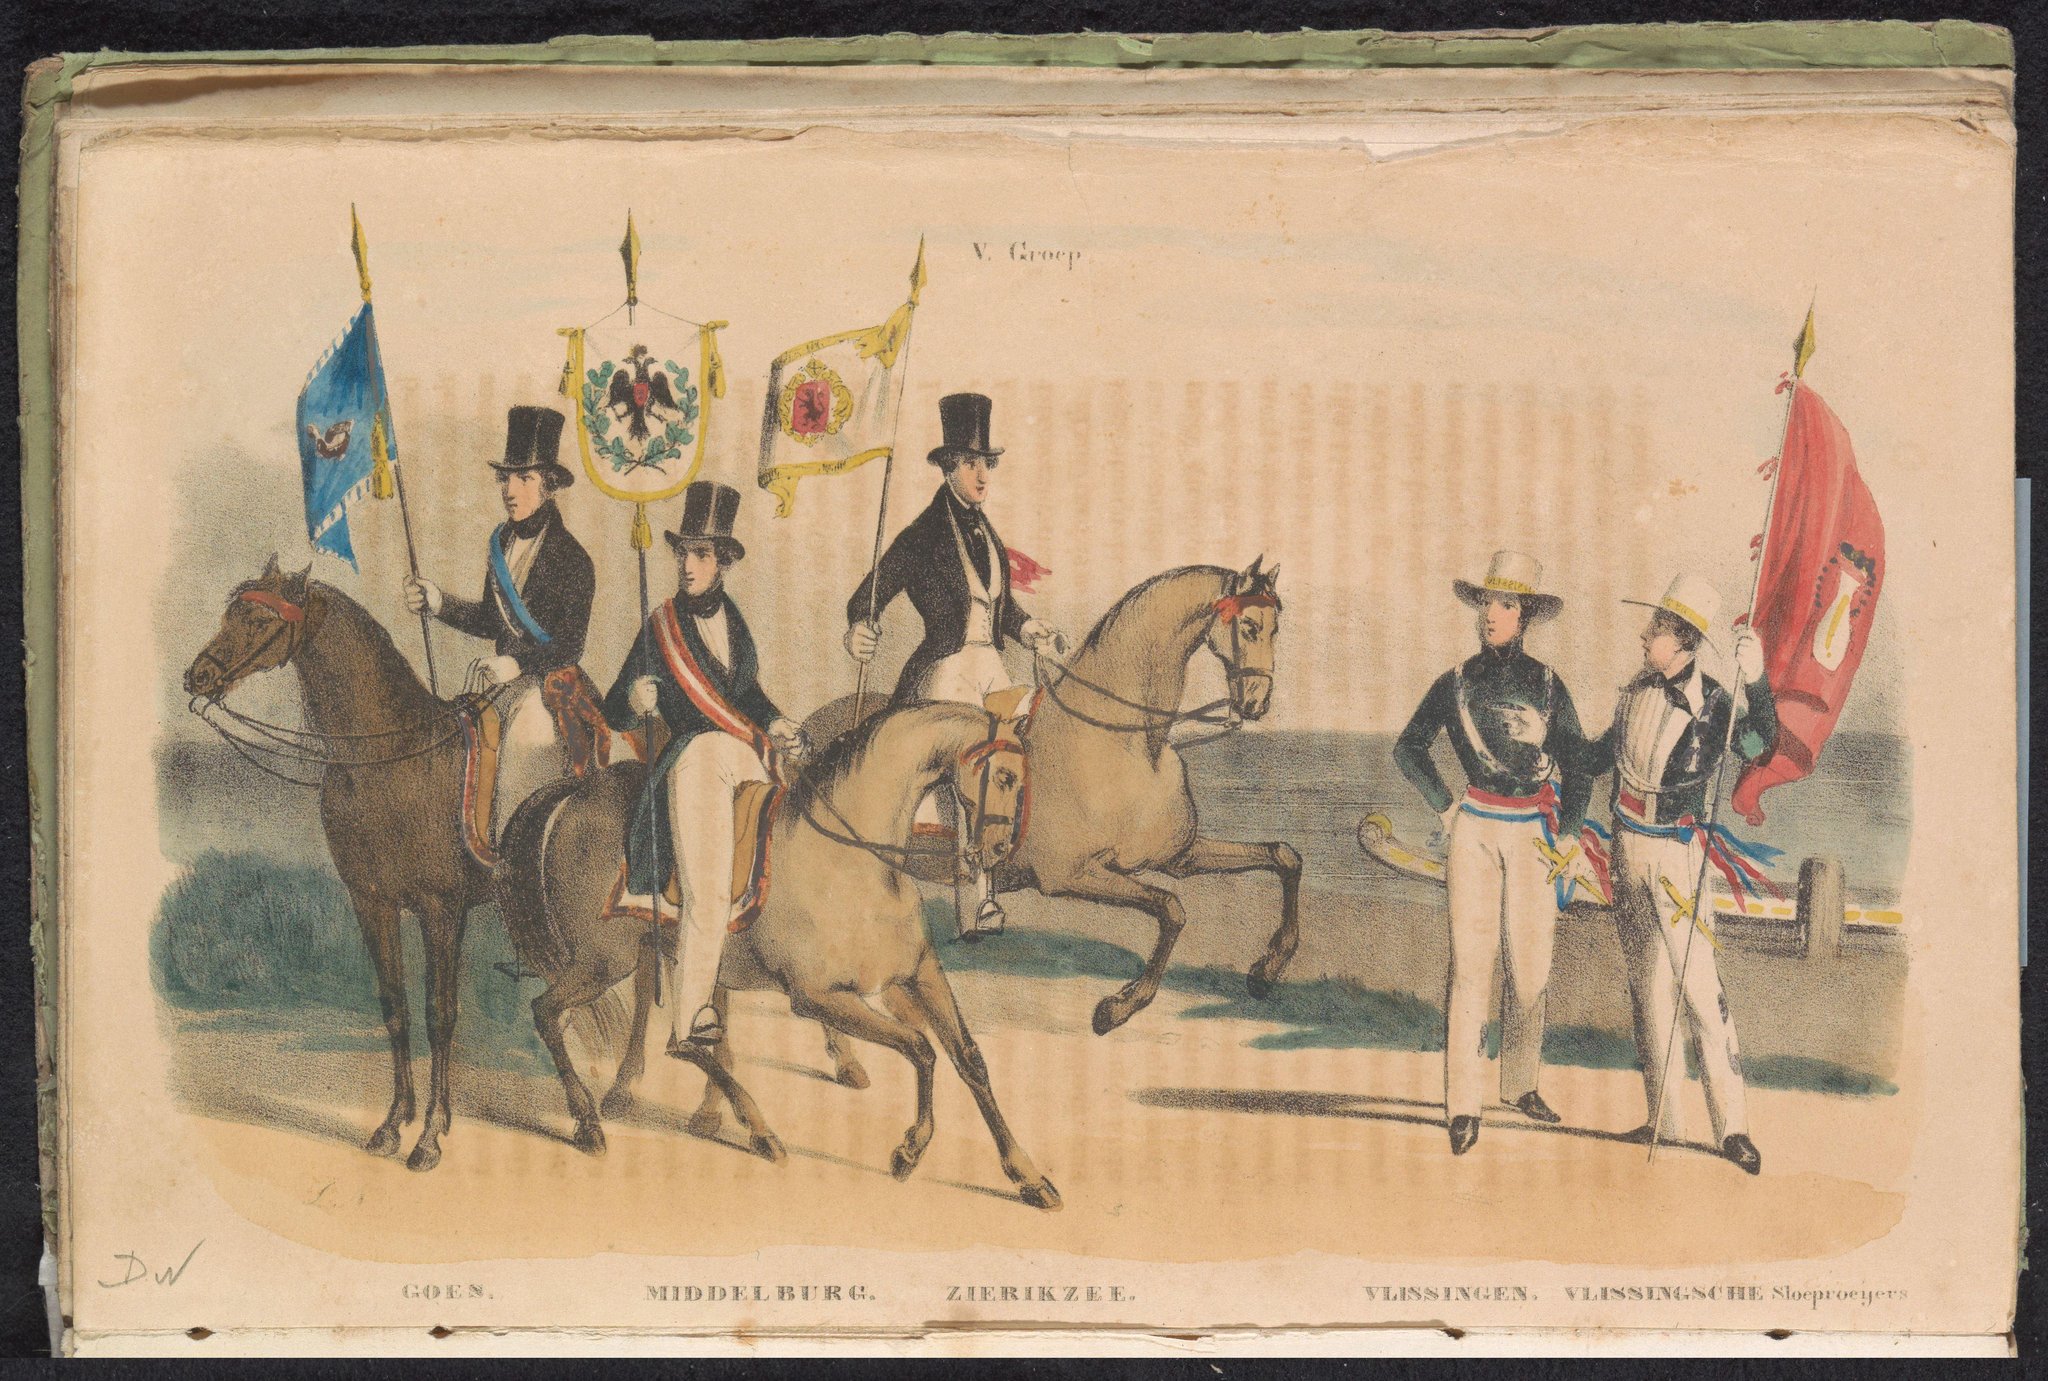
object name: book illustration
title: V. Groep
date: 1840-1842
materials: paper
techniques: hand coloring, lithograph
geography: den bosch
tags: the hague, william ii of the netherlands, clothes for official occasions, guard of honour, (military) uniforms, middelburg, flushing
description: Kostumen en vaandels van de burger erewachten van Goes, Middelburg, Zierikzee en Vlissingen, 1840-1842. Drie mannen te paard met vaandels. Rechts twee eresloeproeiers uit Vlissingen. Illustratie in een boek met negen platen van de kleding gedragen door de burgererewachten tijdens het bezoek van koning Willem II aan die stad na zijn inhuldiging in 1840.